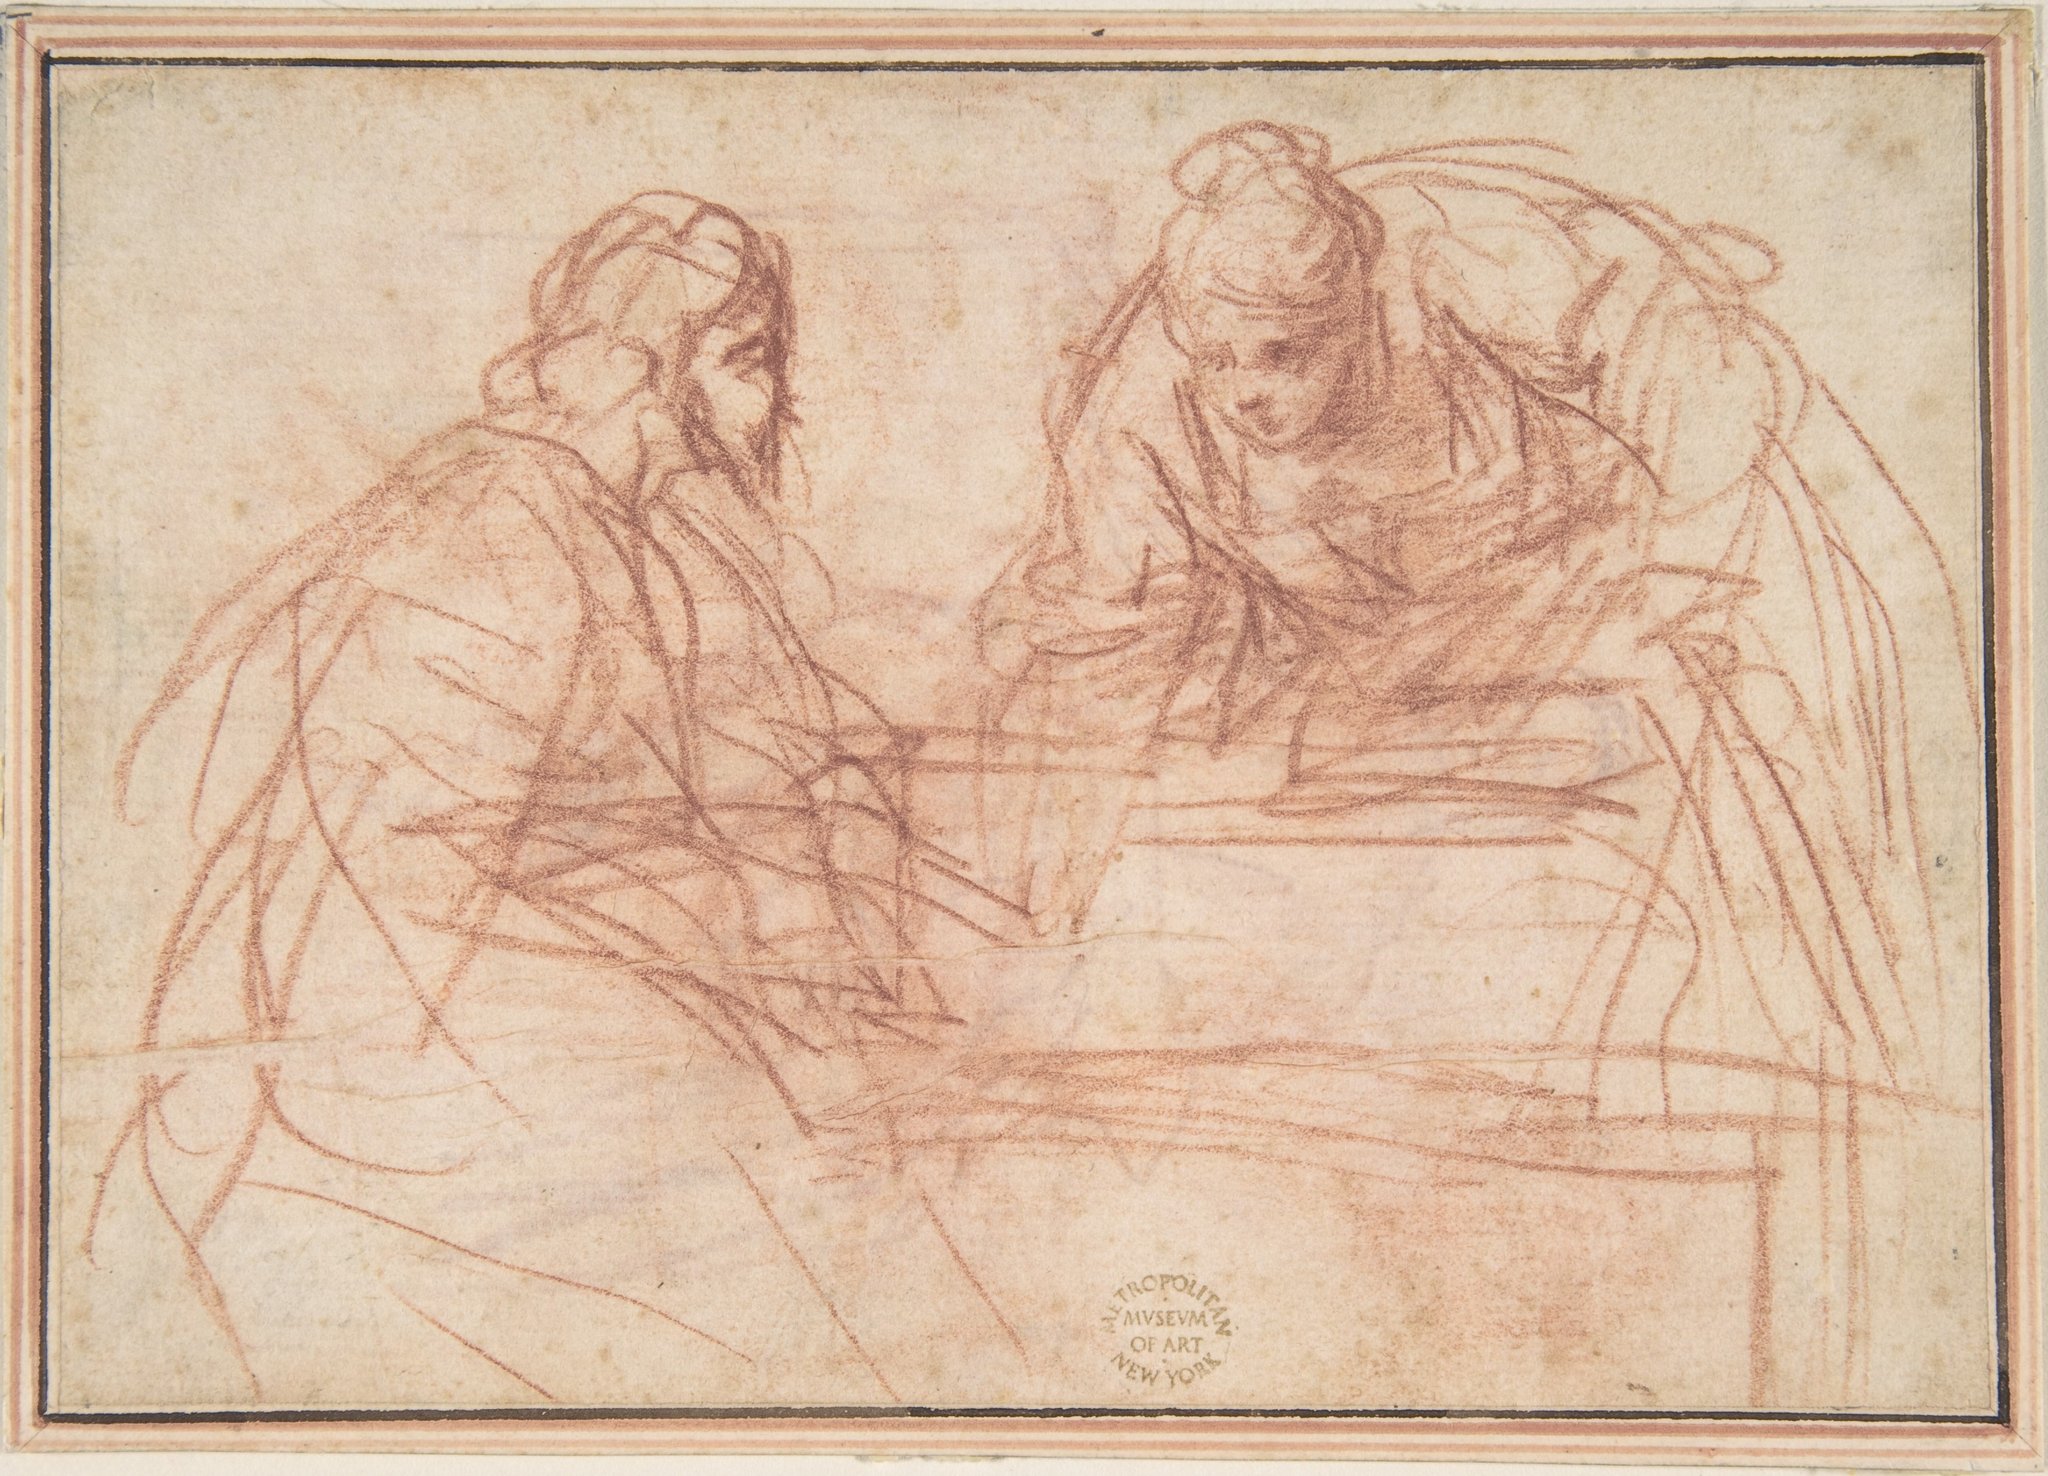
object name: drawing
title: Christ and the Woman of Samaria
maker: anonymous, italian, venetian, 15th to 16th century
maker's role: artist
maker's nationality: italian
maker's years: 1400-1600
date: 1501-1600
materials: chalk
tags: women,christ